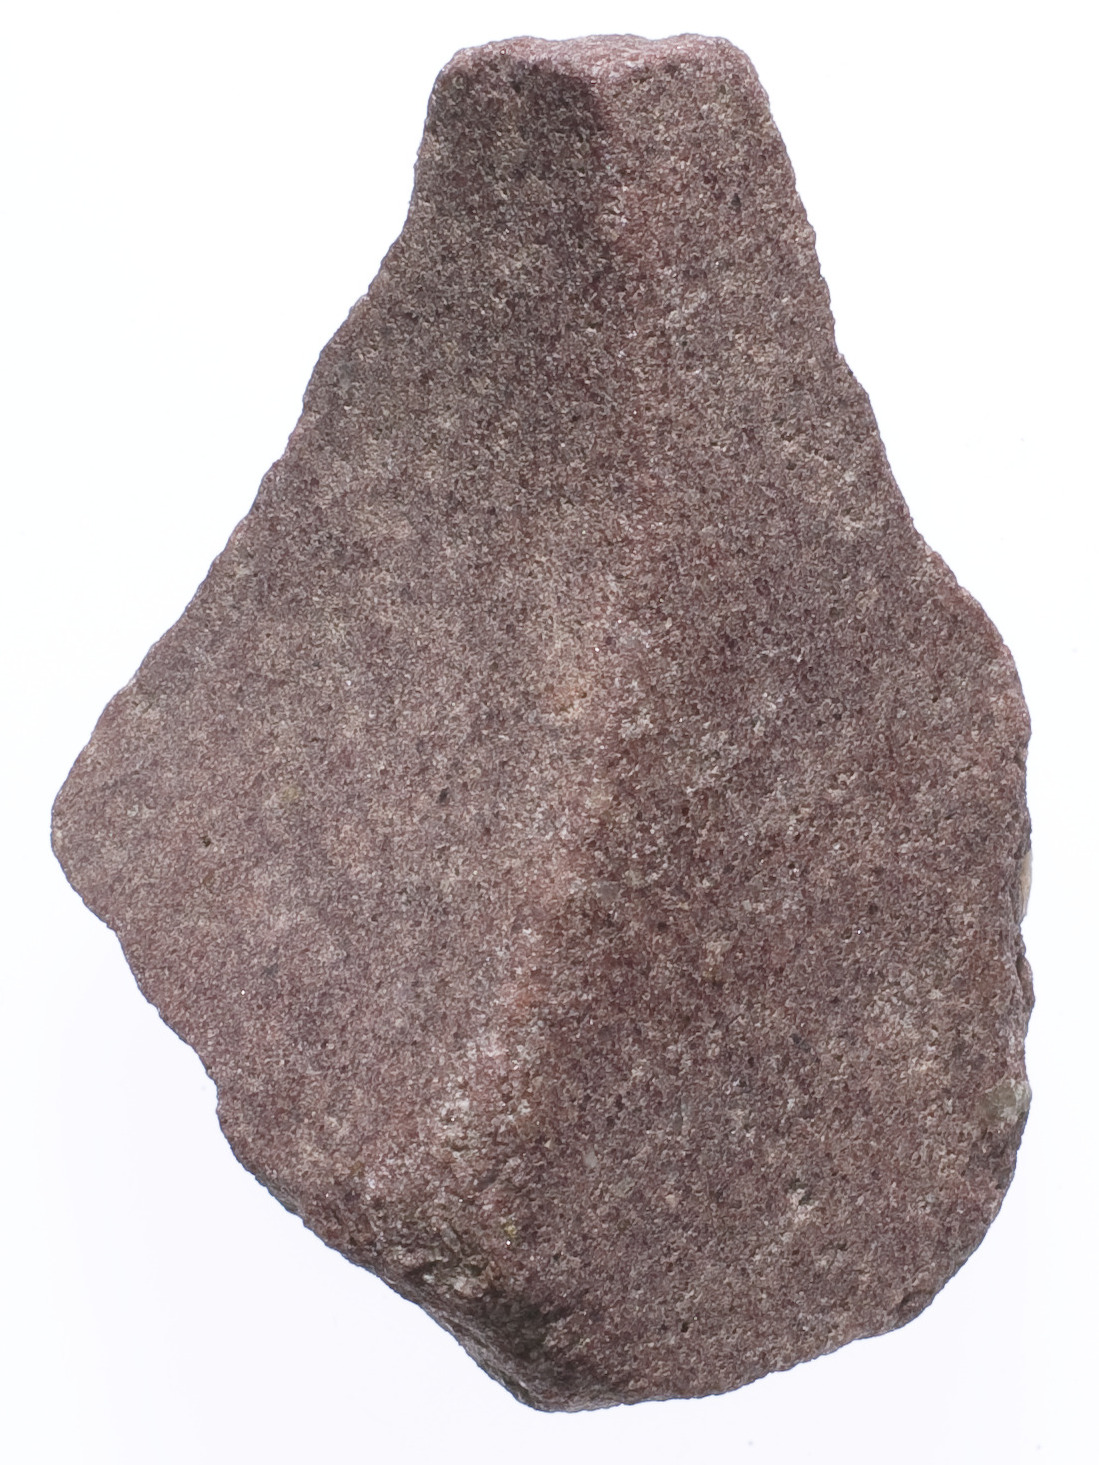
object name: curved surface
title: Flat surface and part of the curved wall of depression for an Aten disk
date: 1353-1336 BCE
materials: quartzite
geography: egypt